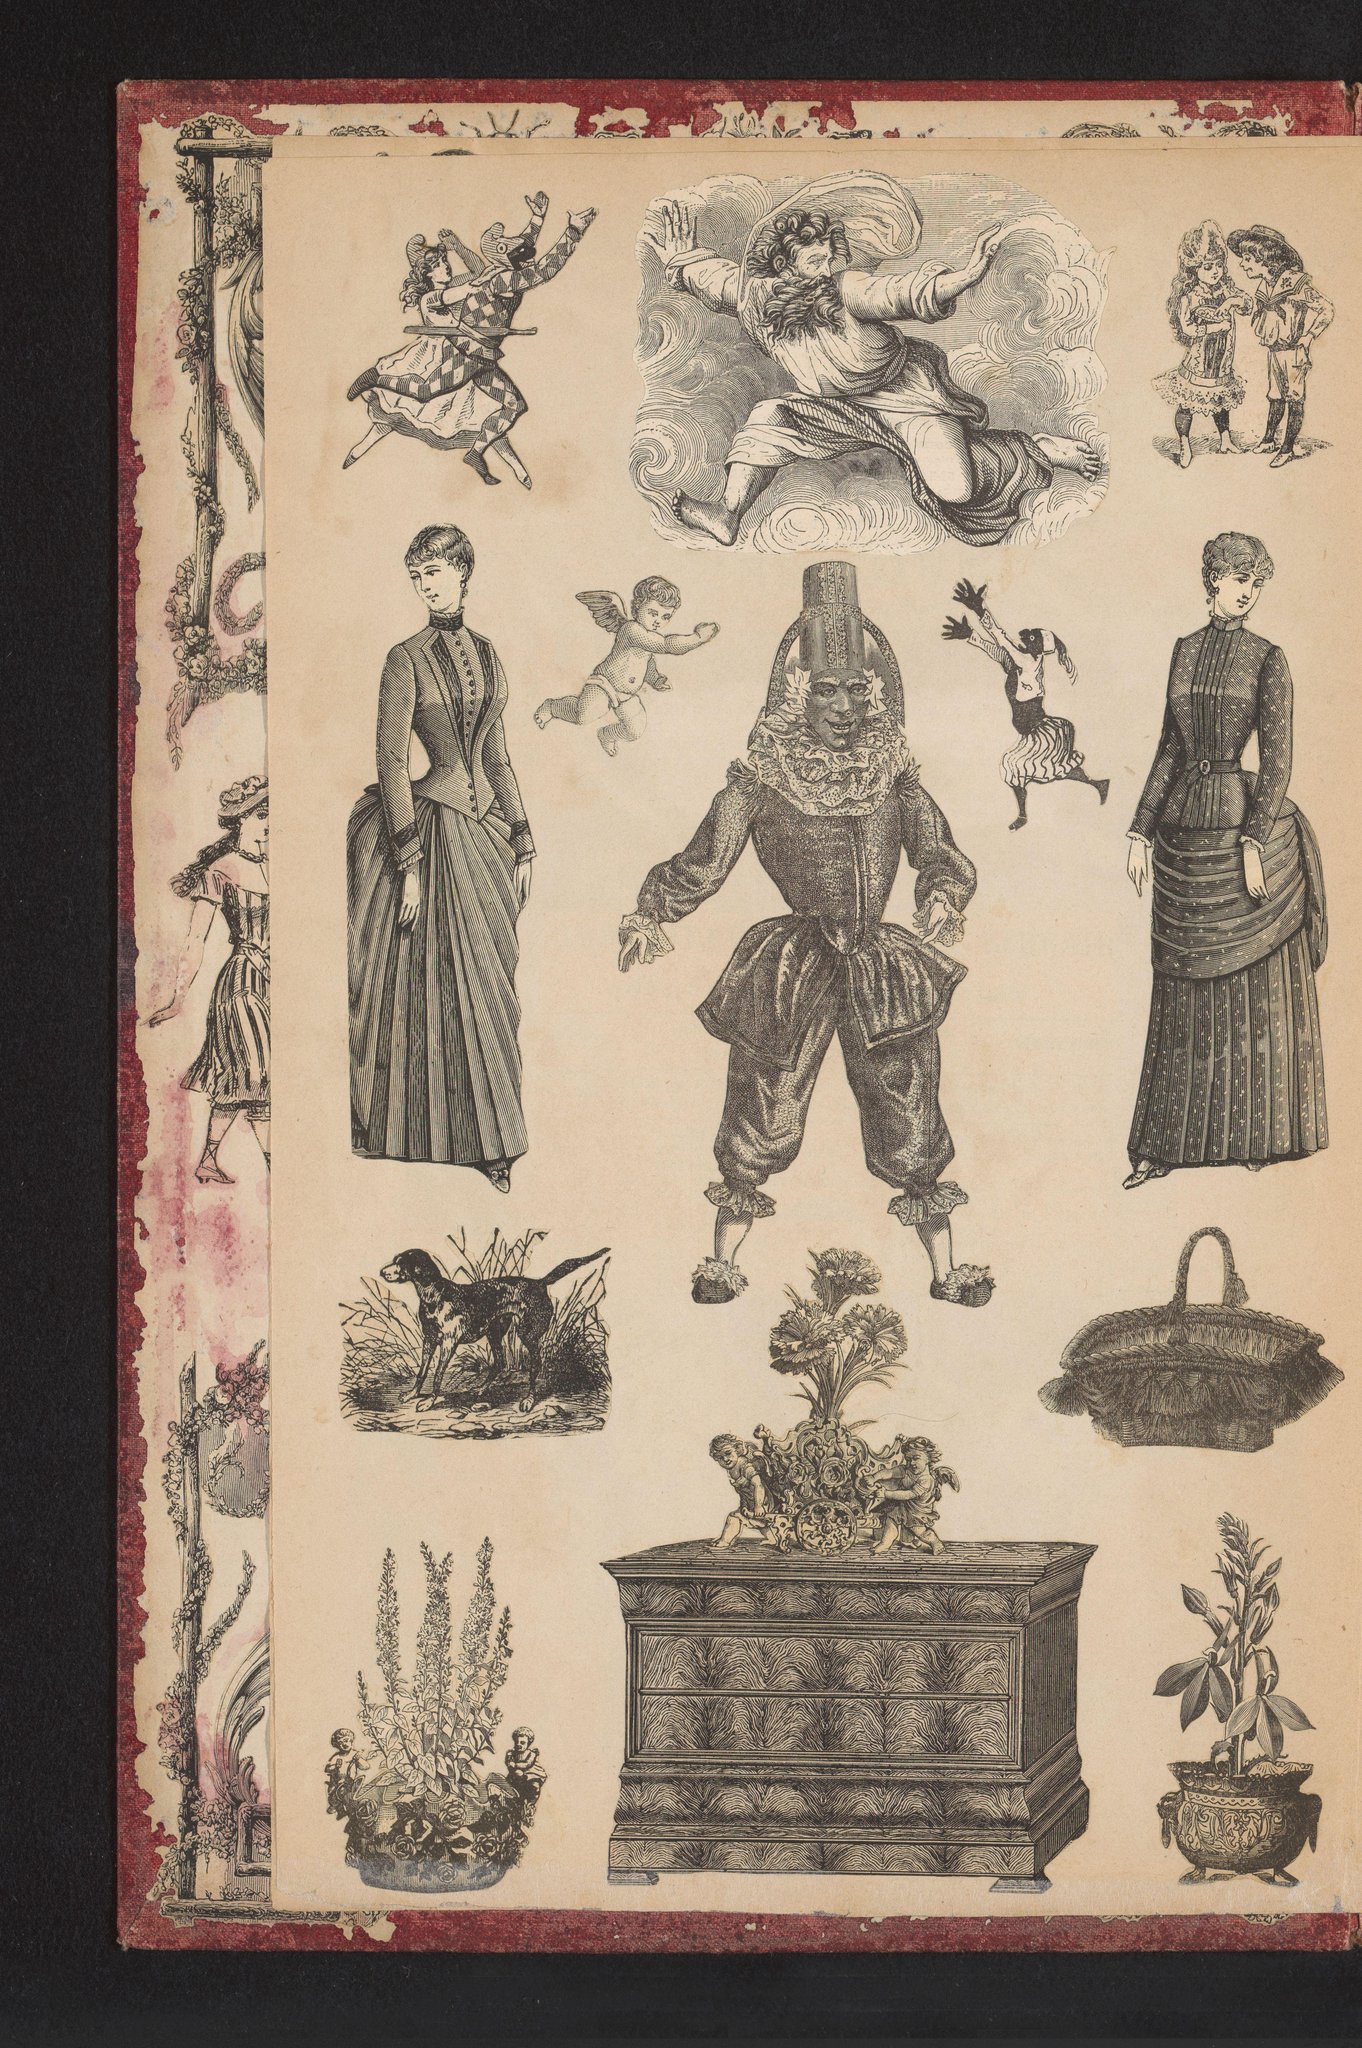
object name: collage visual work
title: Collage van uitgeknipte prenten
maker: Anonymous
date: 1870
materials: paper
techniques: engraving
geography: paris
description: Collage van uitgeknipte prenten. Onderdeel van een album met 32 bladen, aan beide zijden beplakt met uitgeknipte prenten, vermoedelijk afkomstig uit 19e-eeuwse tijdschiften.